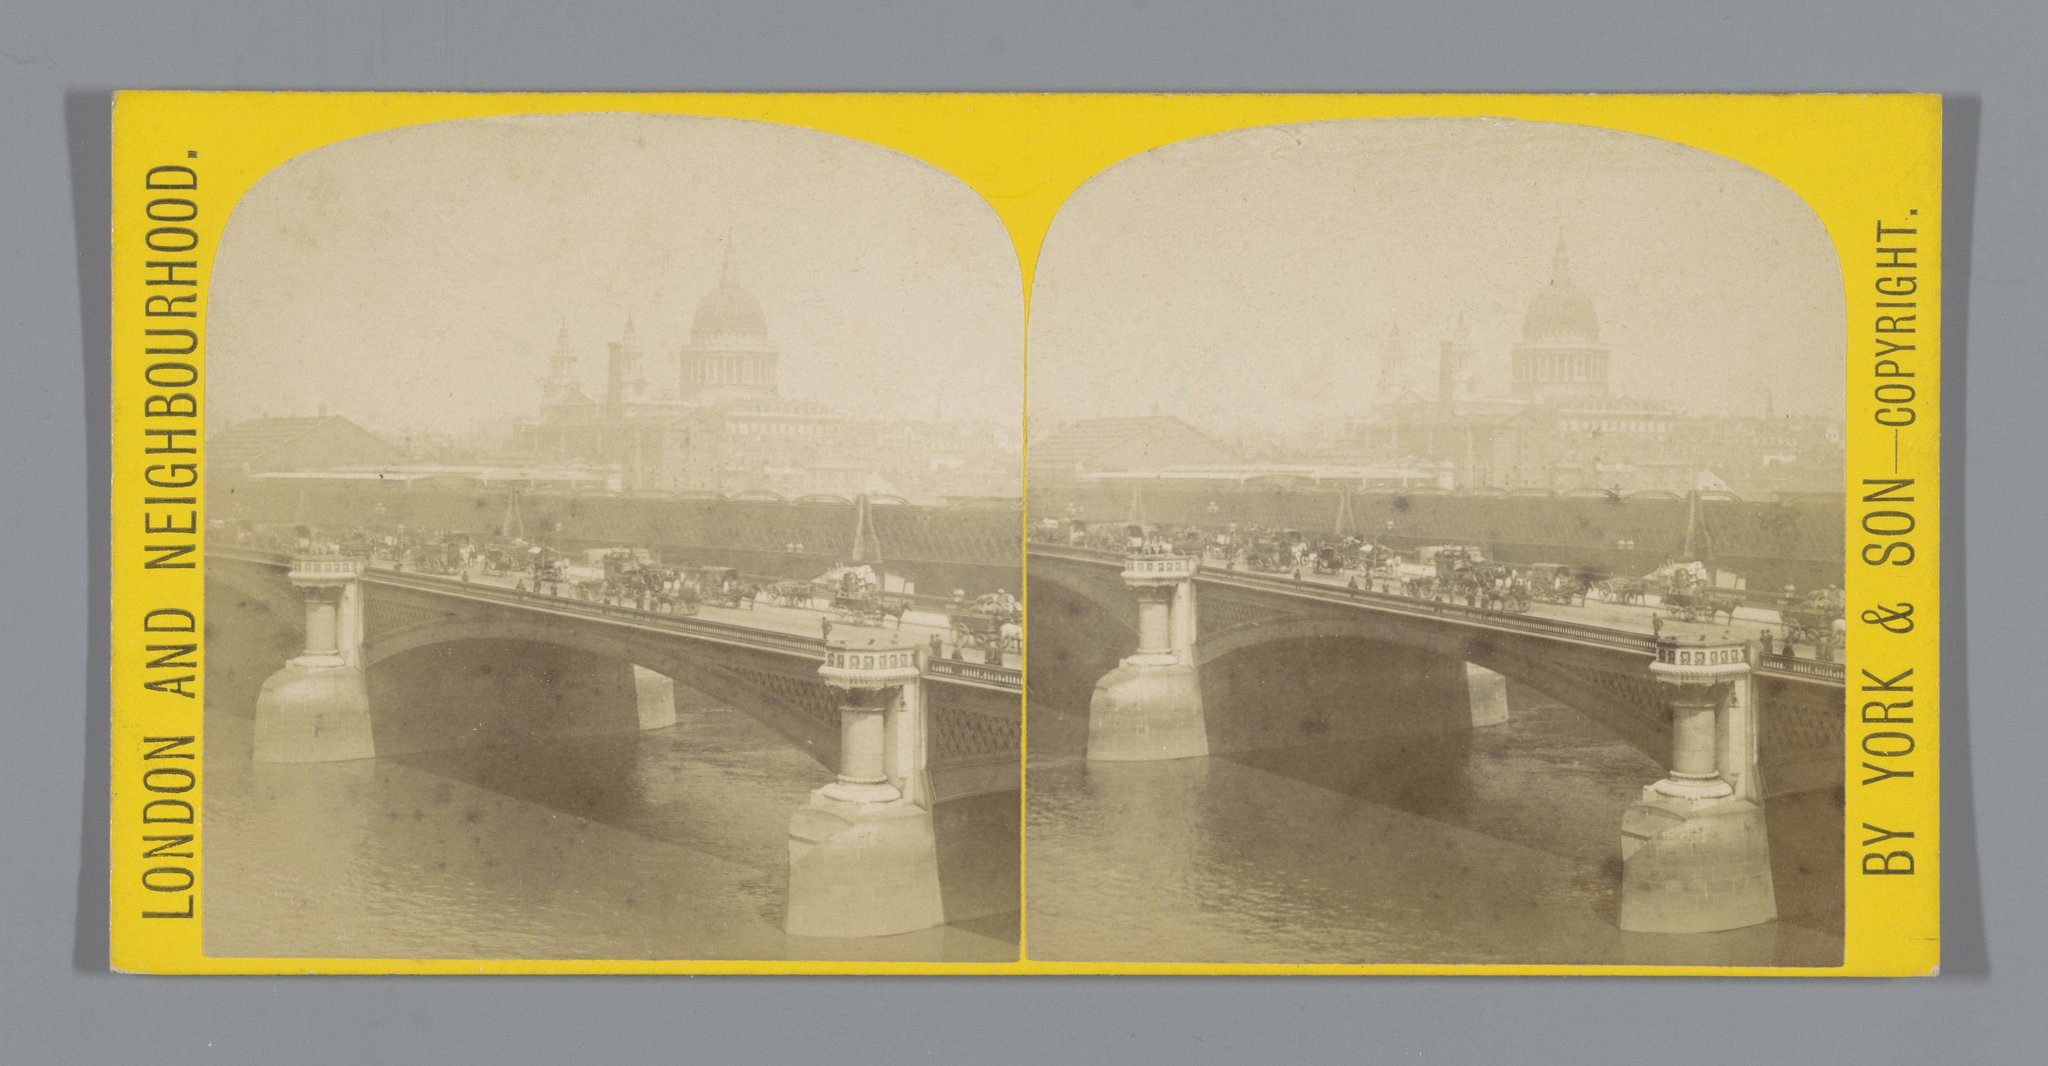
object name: stereograph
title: Blackfriars Bridge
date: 1860-1880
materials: cardboard, photographic support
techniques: albumen print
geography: london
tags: bridge in city across river, canal, etc.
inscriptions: number: ‘No. 181.’